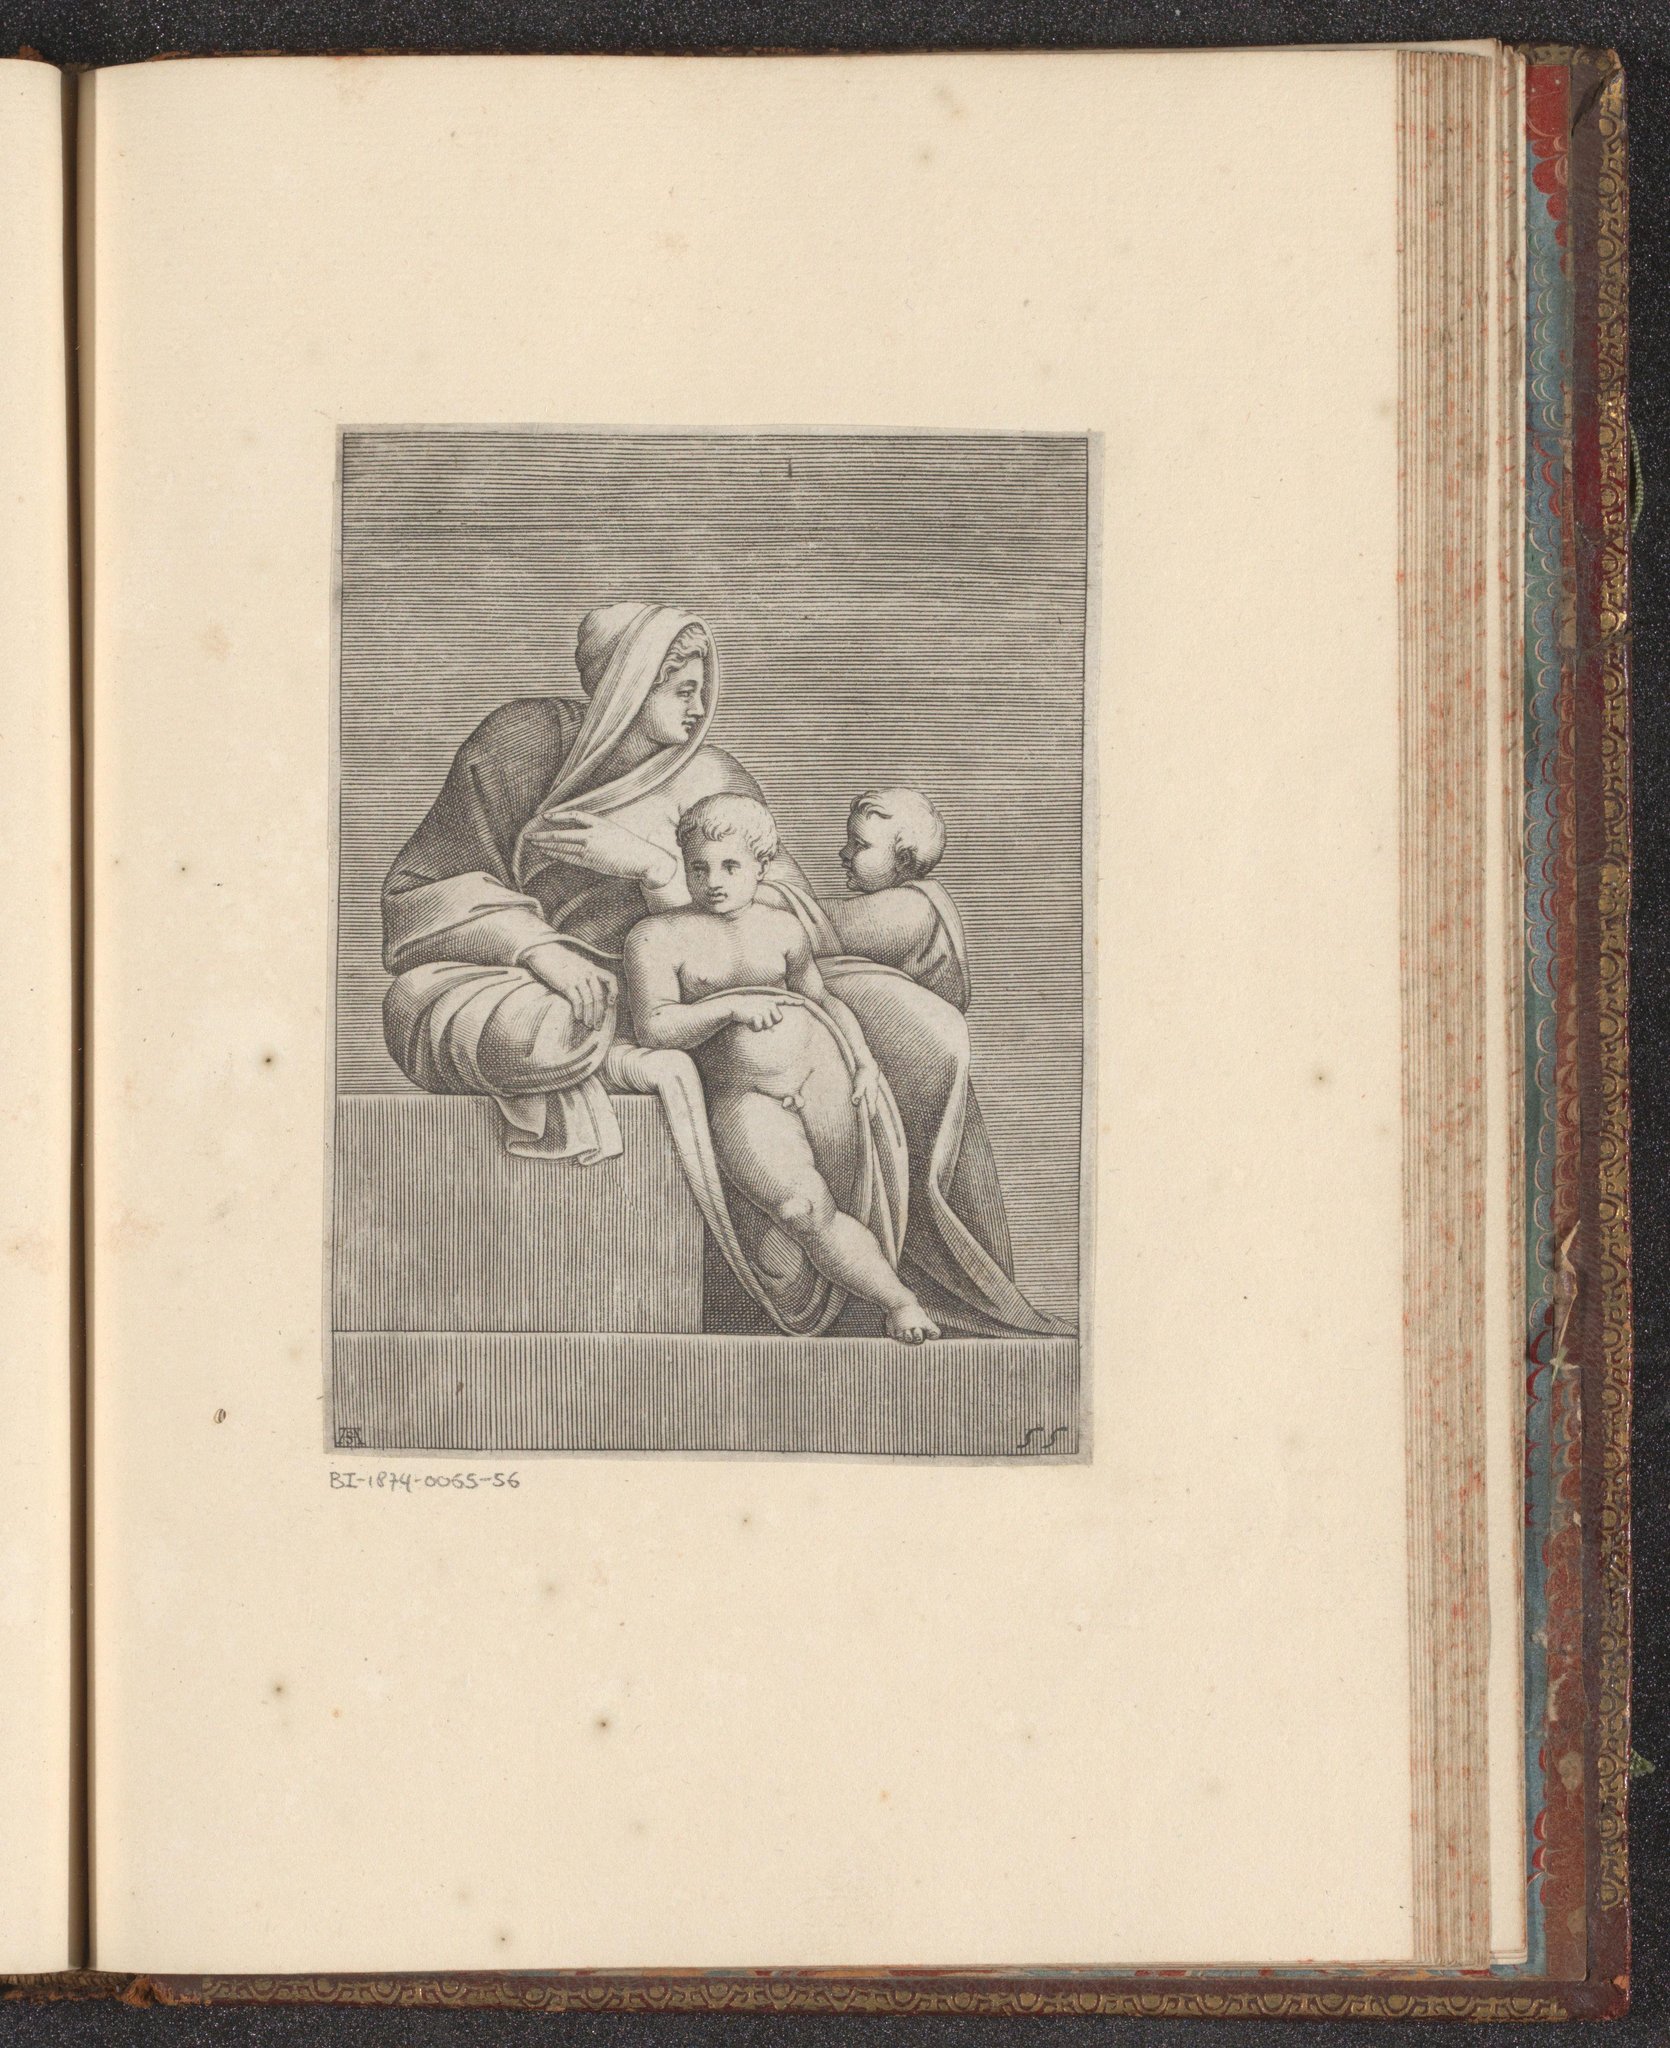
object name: print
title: Zittende vrouw met twee kinderen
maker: adamo scultori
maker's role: painter, print maker, sculptor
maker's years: 1530-1585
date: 1585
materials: paper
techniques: engraving, intaglio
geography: vatican city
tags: mother and child(ren), woman and child(ren) (family group)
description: Deze prent maakt deel uit van een serie bestaande uit een titelprent en 72 prenten naar schilderingen door Michelangelo in de Sixtijnse Kapel in het Vaticaan.